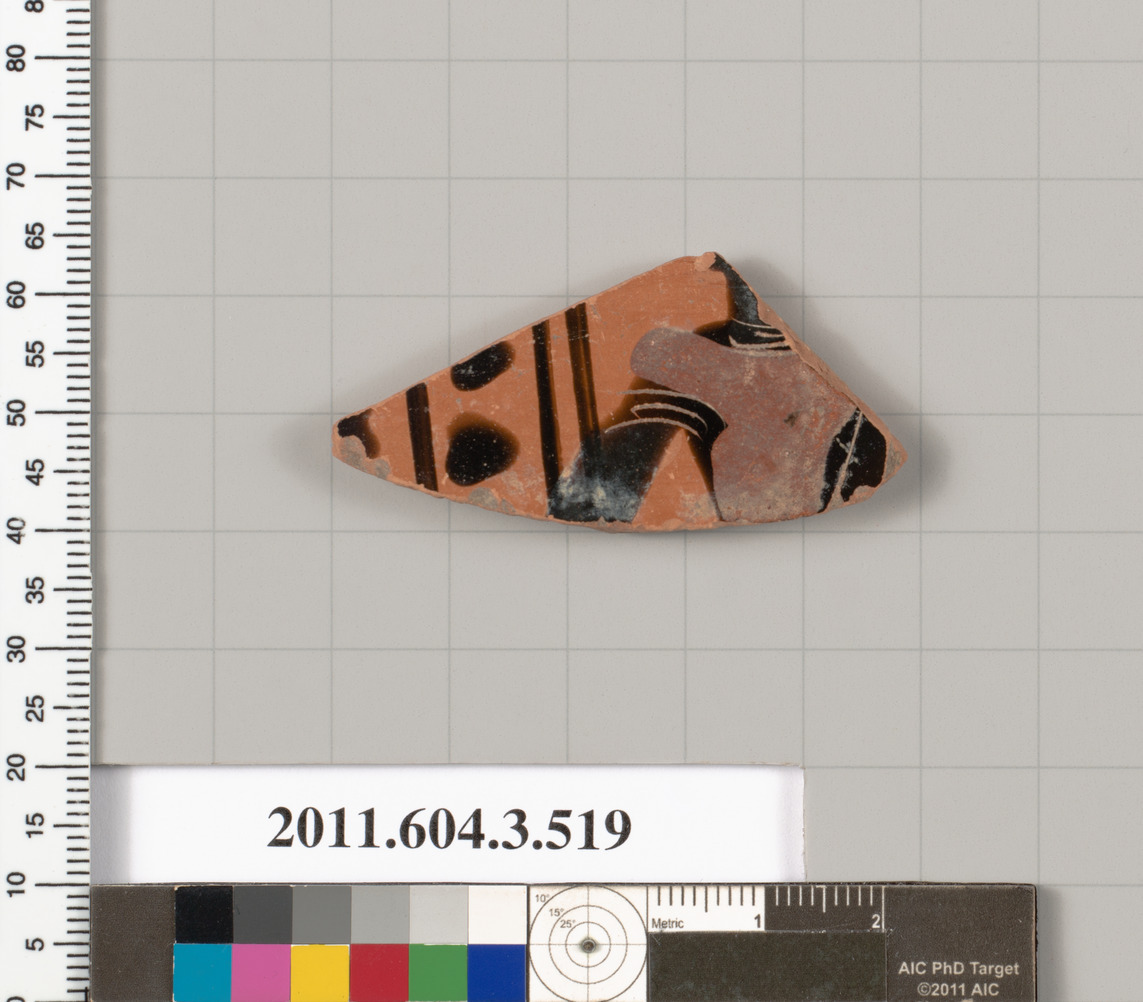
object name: column krater fragment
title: Terracotta fragment of a column-krater (bowl for mixing wine and water)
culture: greek, attic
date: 510 BCE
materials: terracotta